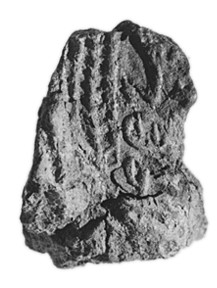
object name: sealing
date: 2030-1640 BCE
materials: clay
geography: egypt